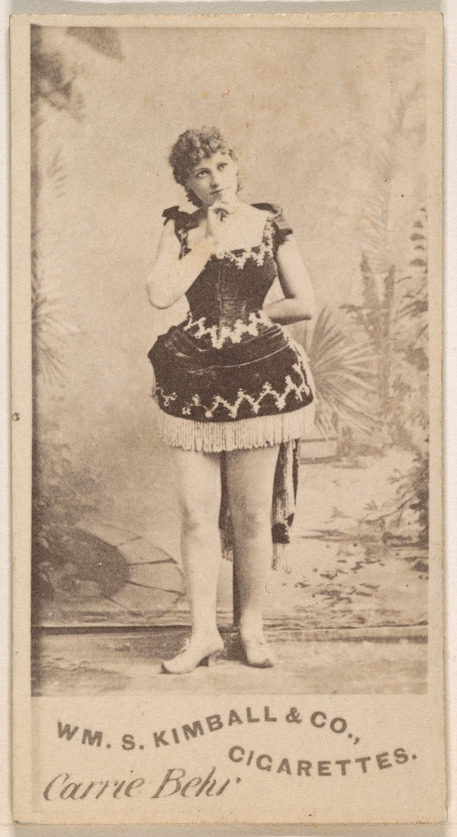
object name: photograph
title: Carrie Behr, from the Actresses series (N203) issued by Wm. S. Kimball & Co.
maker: william s. kimball & company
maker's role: publisher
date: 1889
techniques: color lithograph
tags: portraits,women,actresses